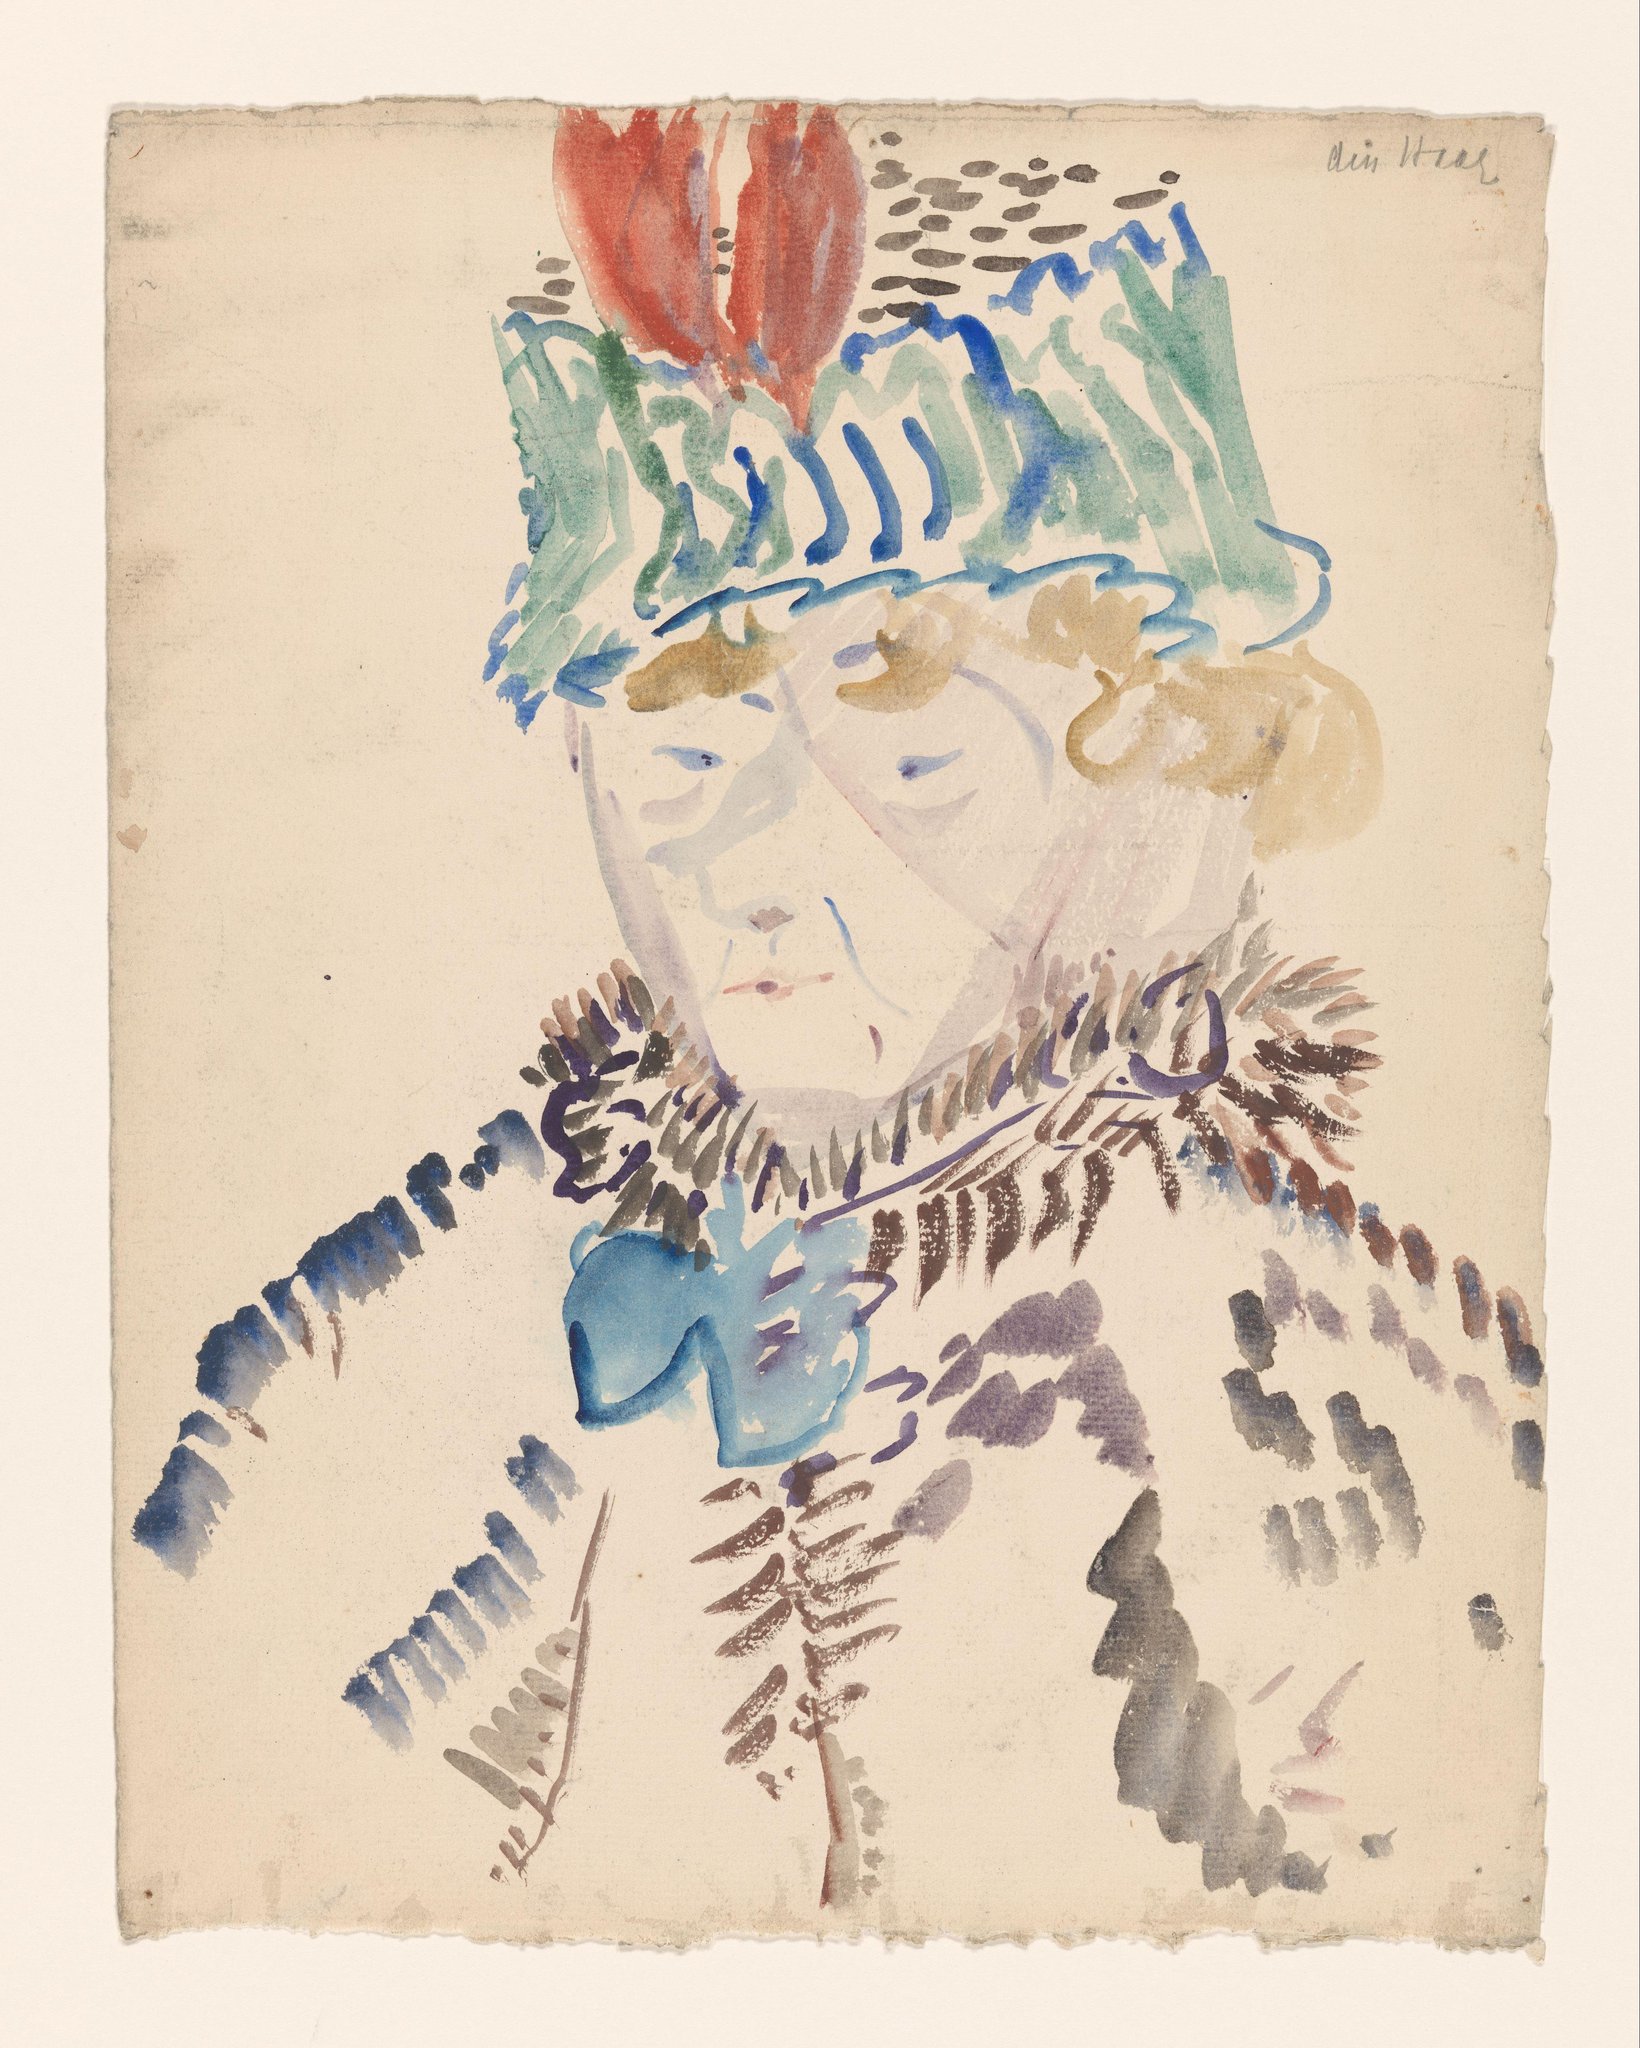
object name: drawing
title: Vrouw in bontkraag en muts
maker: wilhelmus johannes steenhoff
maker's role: draughtsman, print maker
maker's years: 1863-1932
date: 1873-1932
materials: paper, watercolor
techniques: brush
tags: head-gear: cap (+ women's clothes)